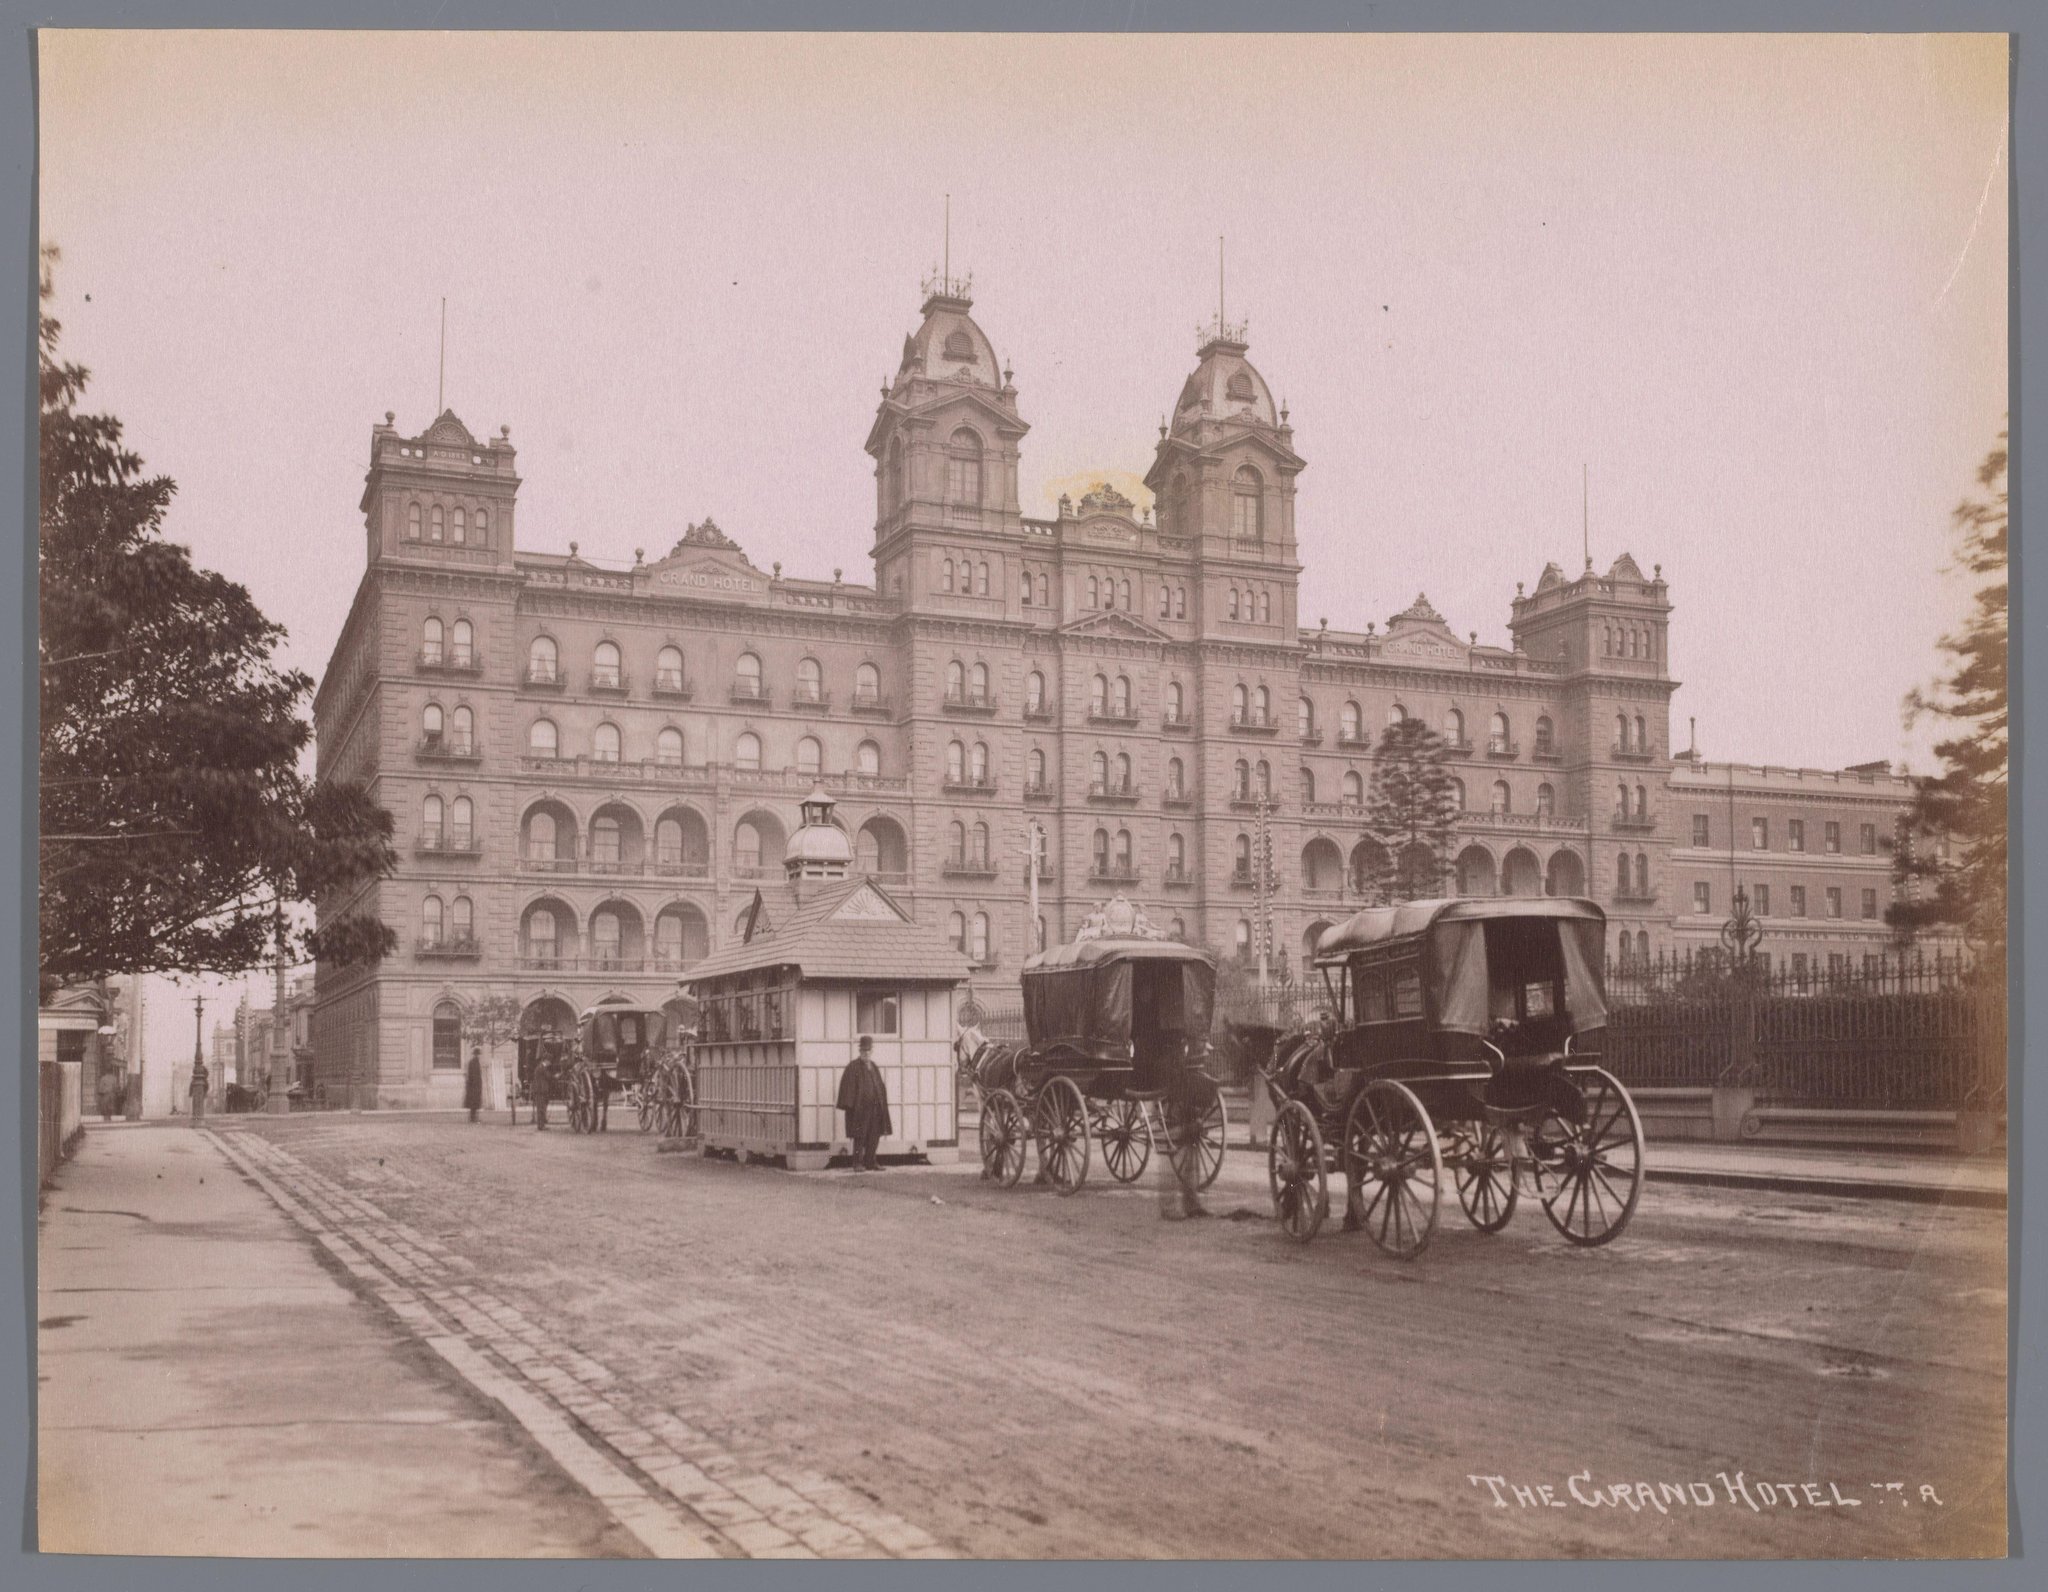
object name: photograph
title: Rijtuigen voor Hotel Windsor in Melbourne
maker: Anonymous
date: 1883-1900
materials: paper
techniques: albumen print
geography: melbourne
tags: passenger carriage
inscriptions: number: ‘7a’, inscription: ‘melbourne’